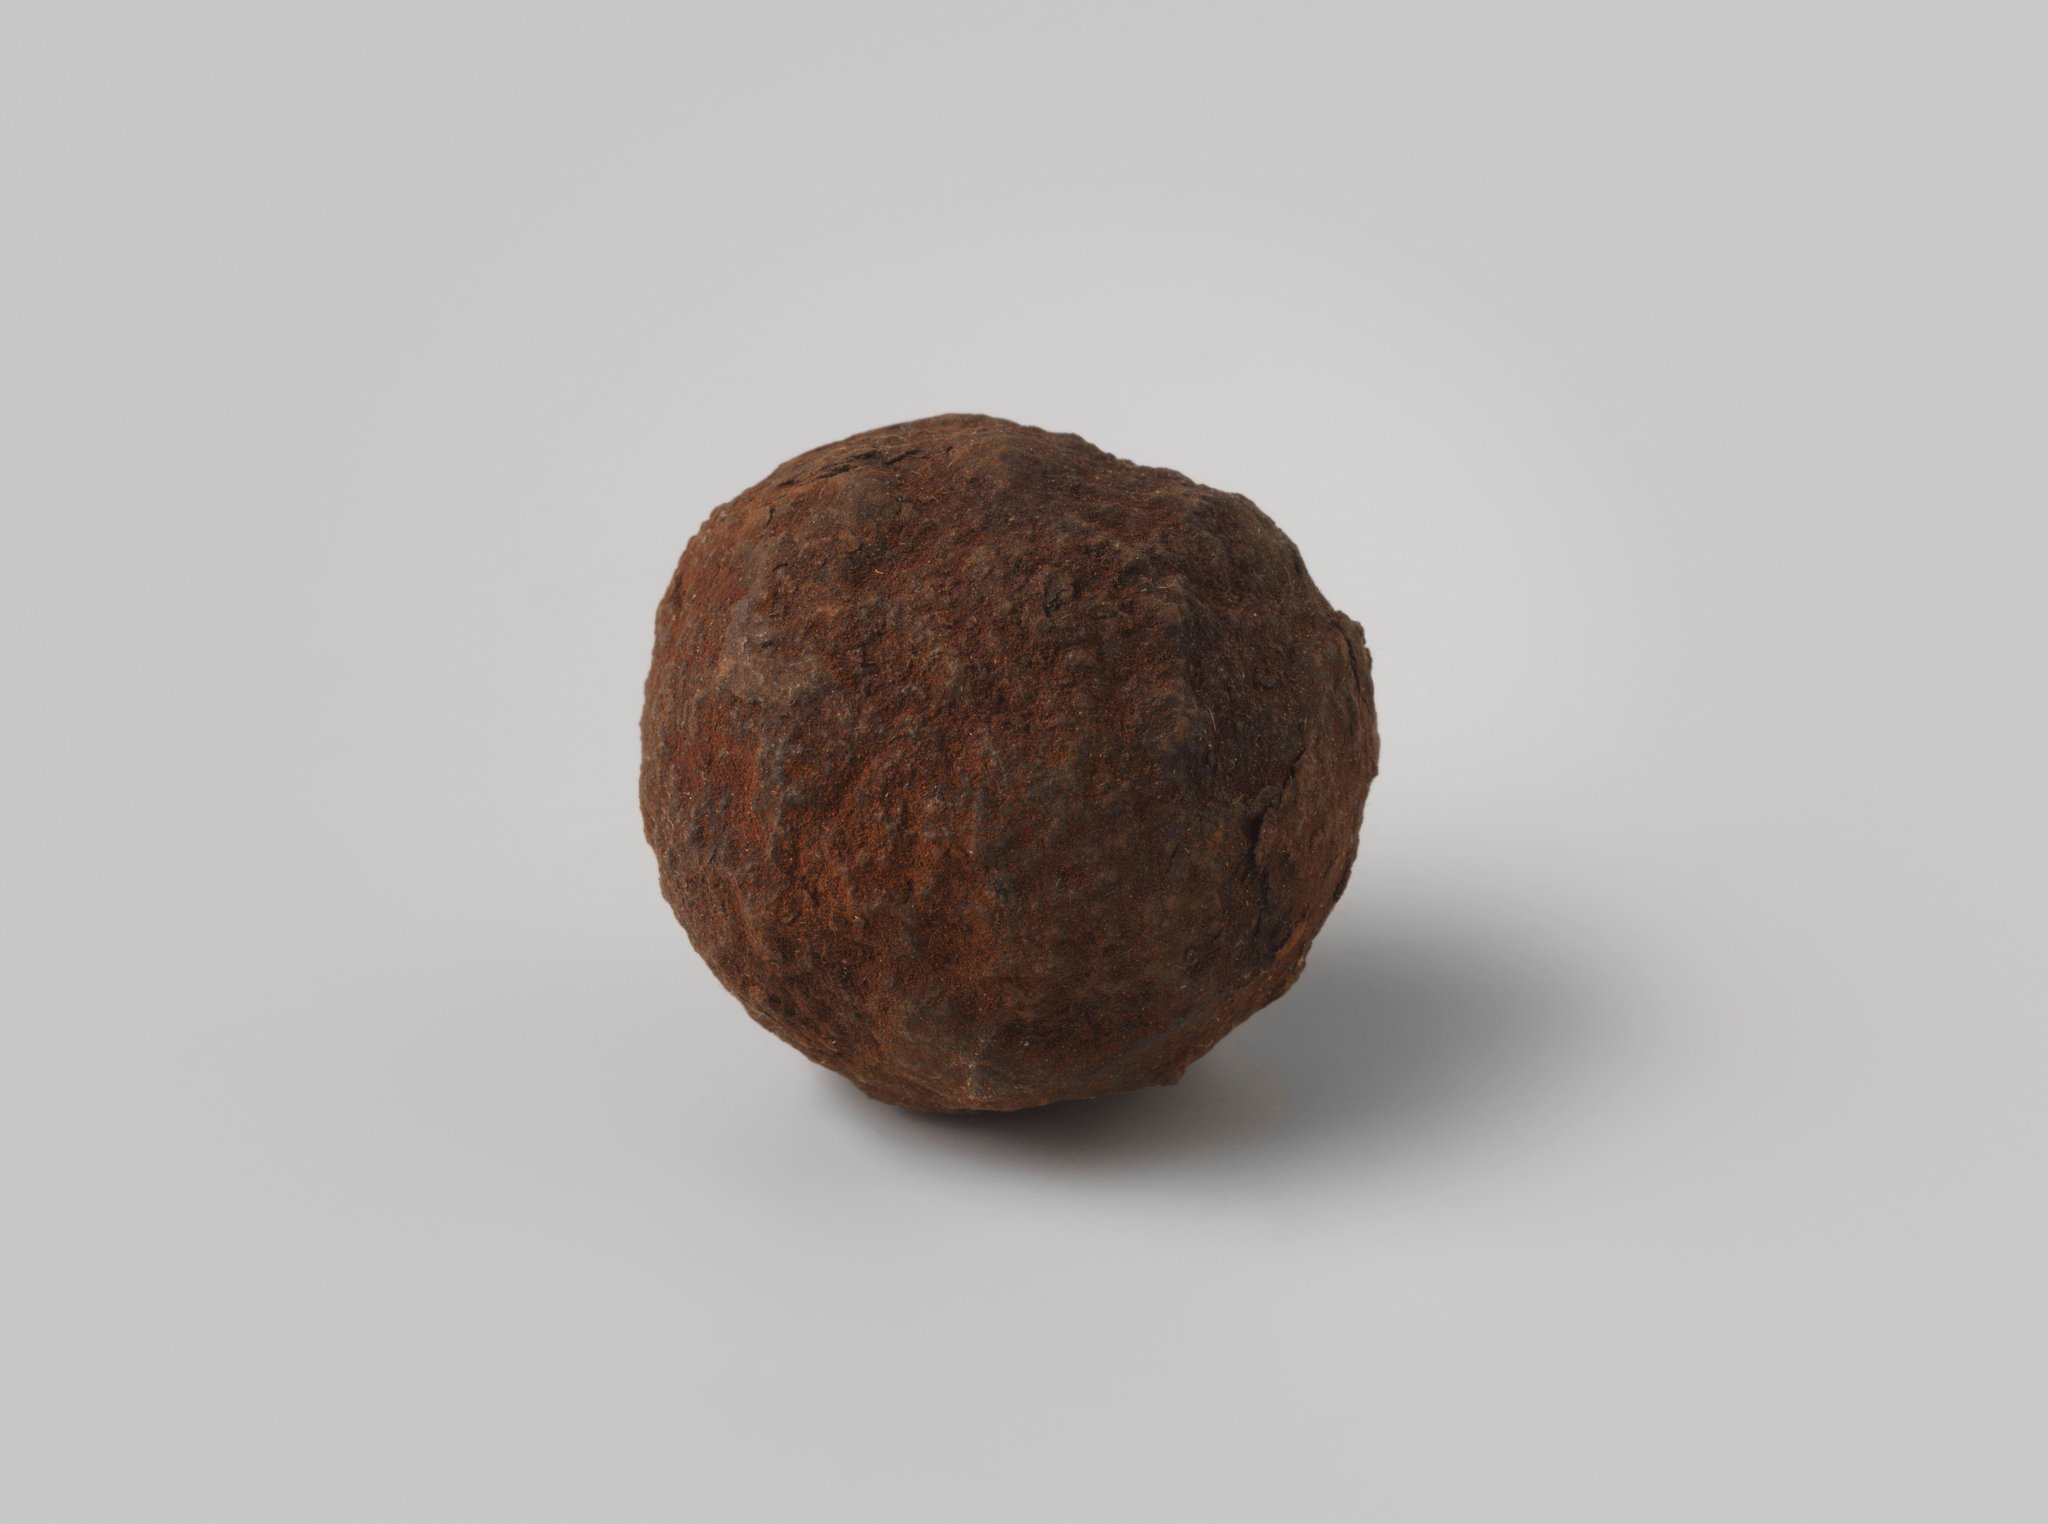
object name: bullet ammunition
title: Kogel uit het wrak van de Oost-Indiëvaarder Hollandia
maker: Anonymous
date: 1700-1743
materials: iron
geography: netherlands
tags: verenigde oostindische compagnie, hollandia (schip), annet